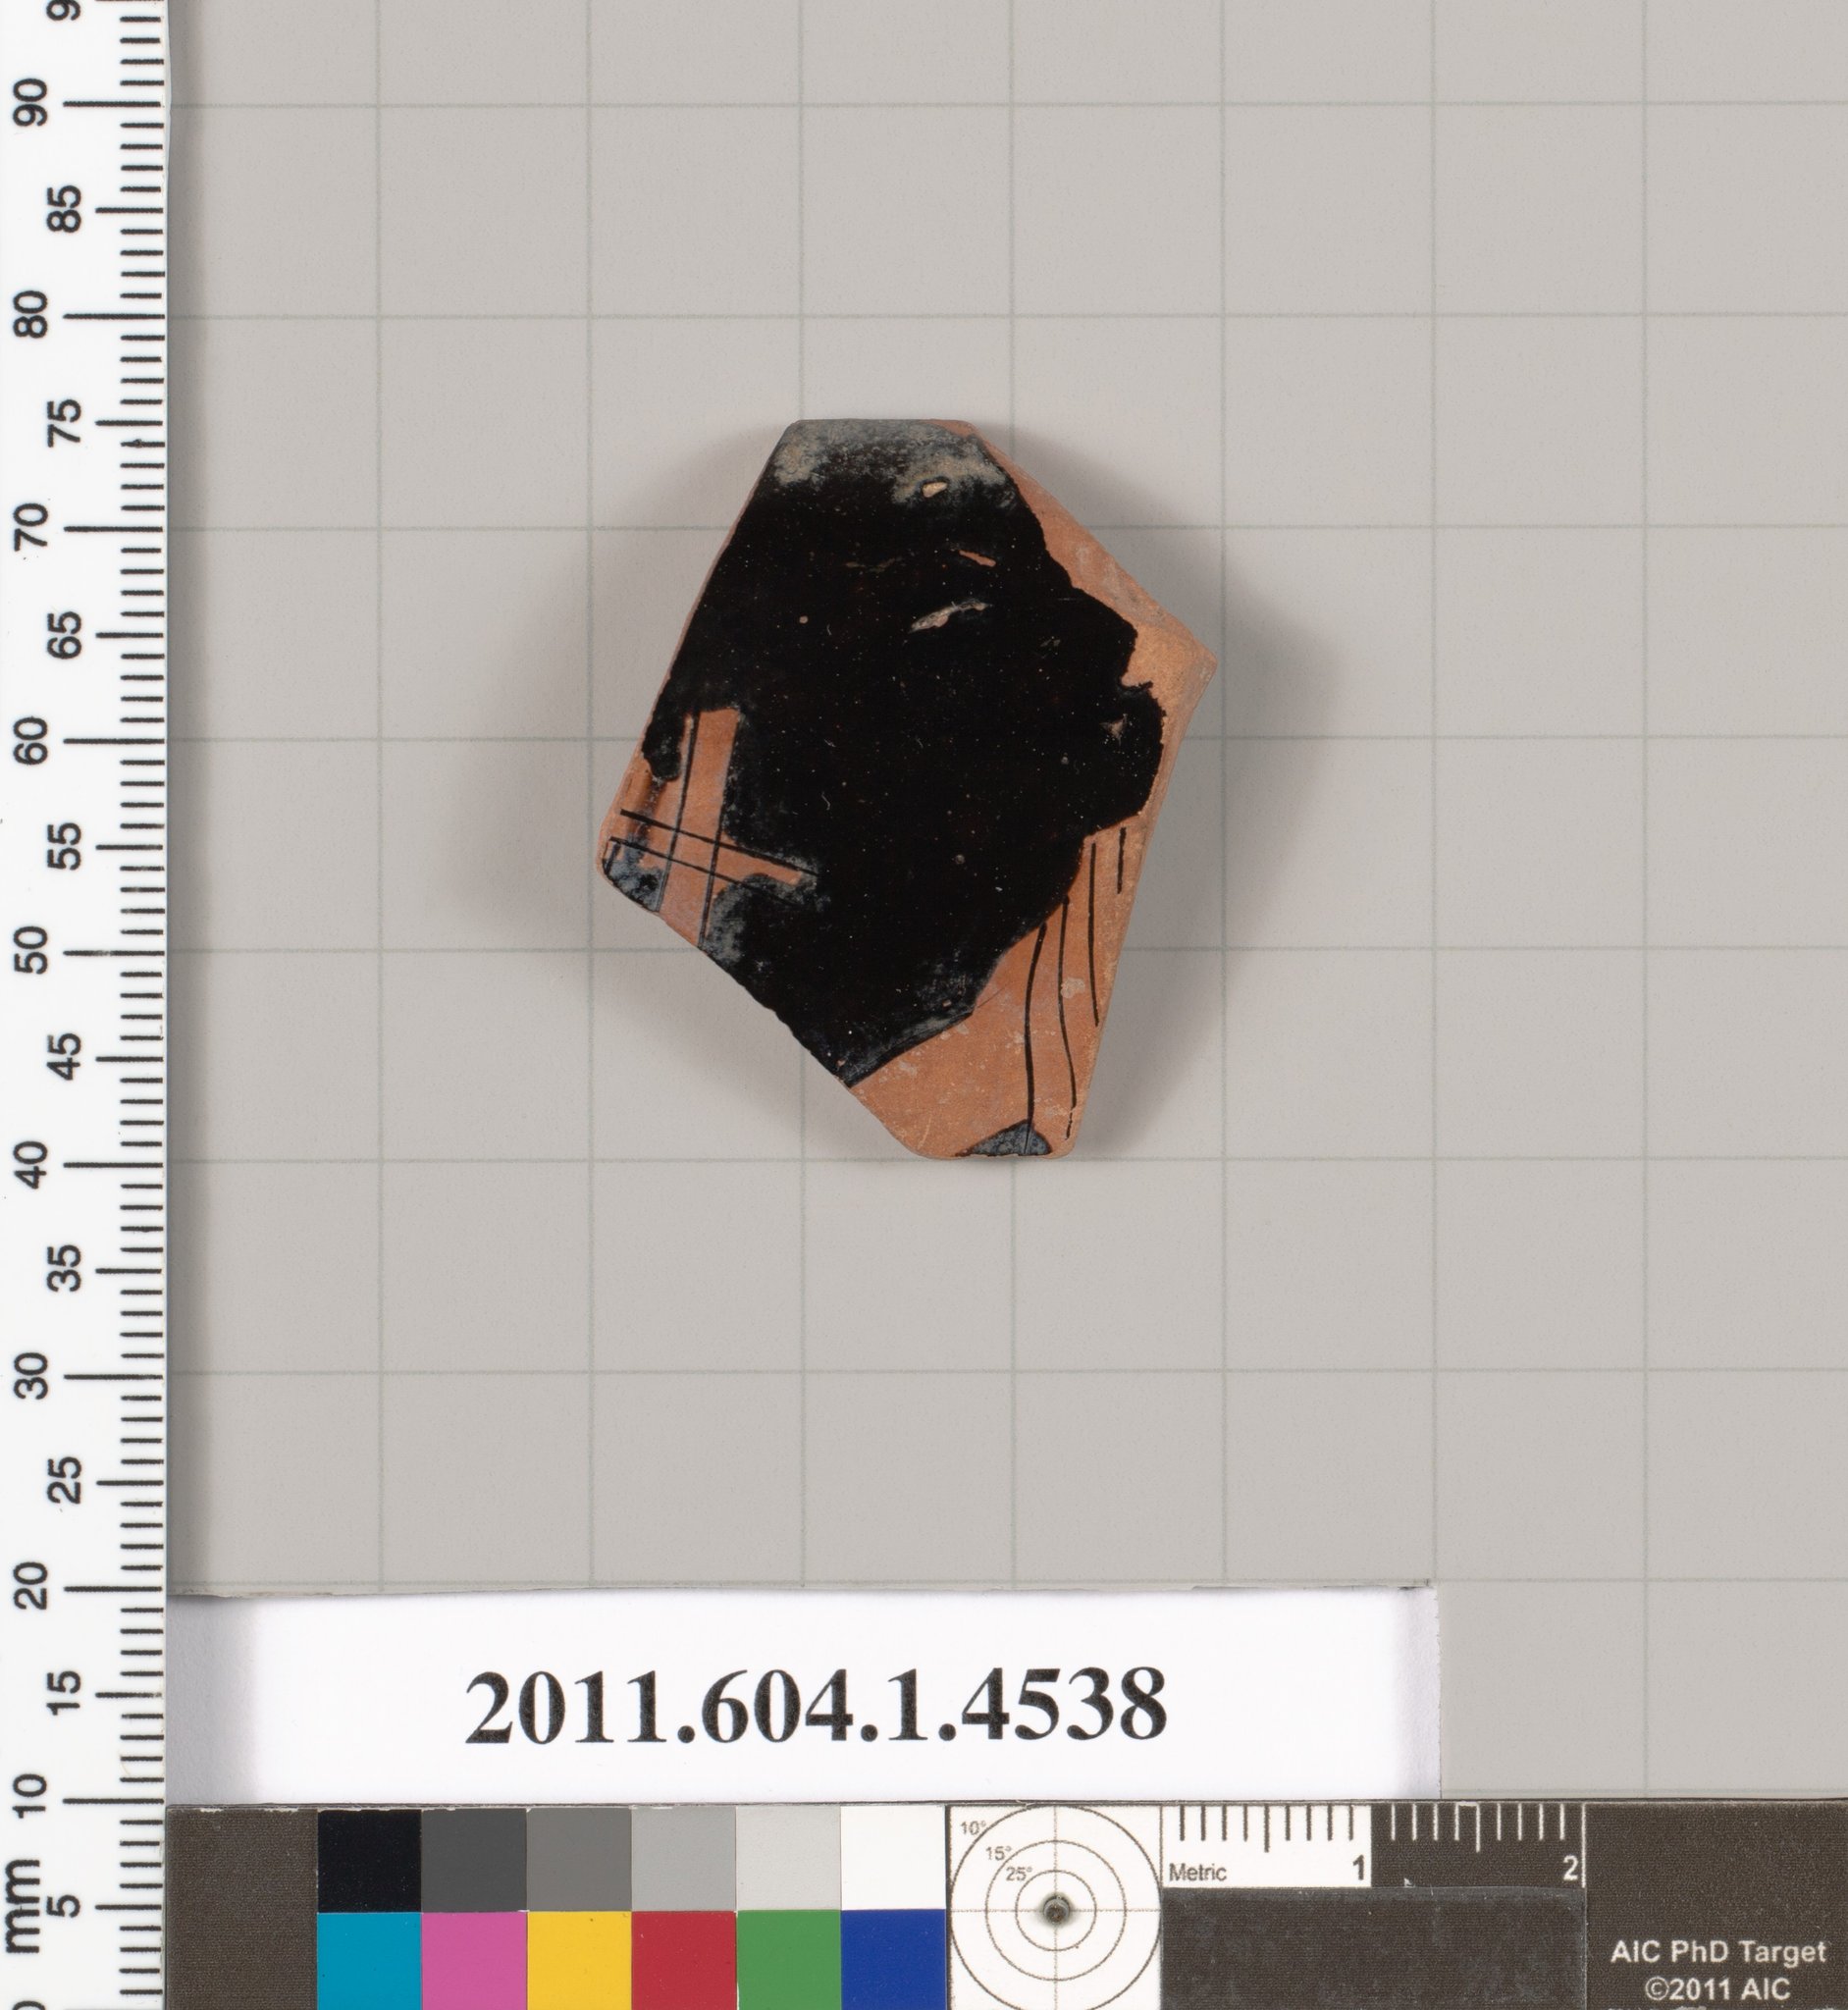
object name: kylix fragment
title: Terracotta rim fragment of a kylix (drinking cup)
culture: greek, attic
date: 475-451 BCE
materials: terracotta